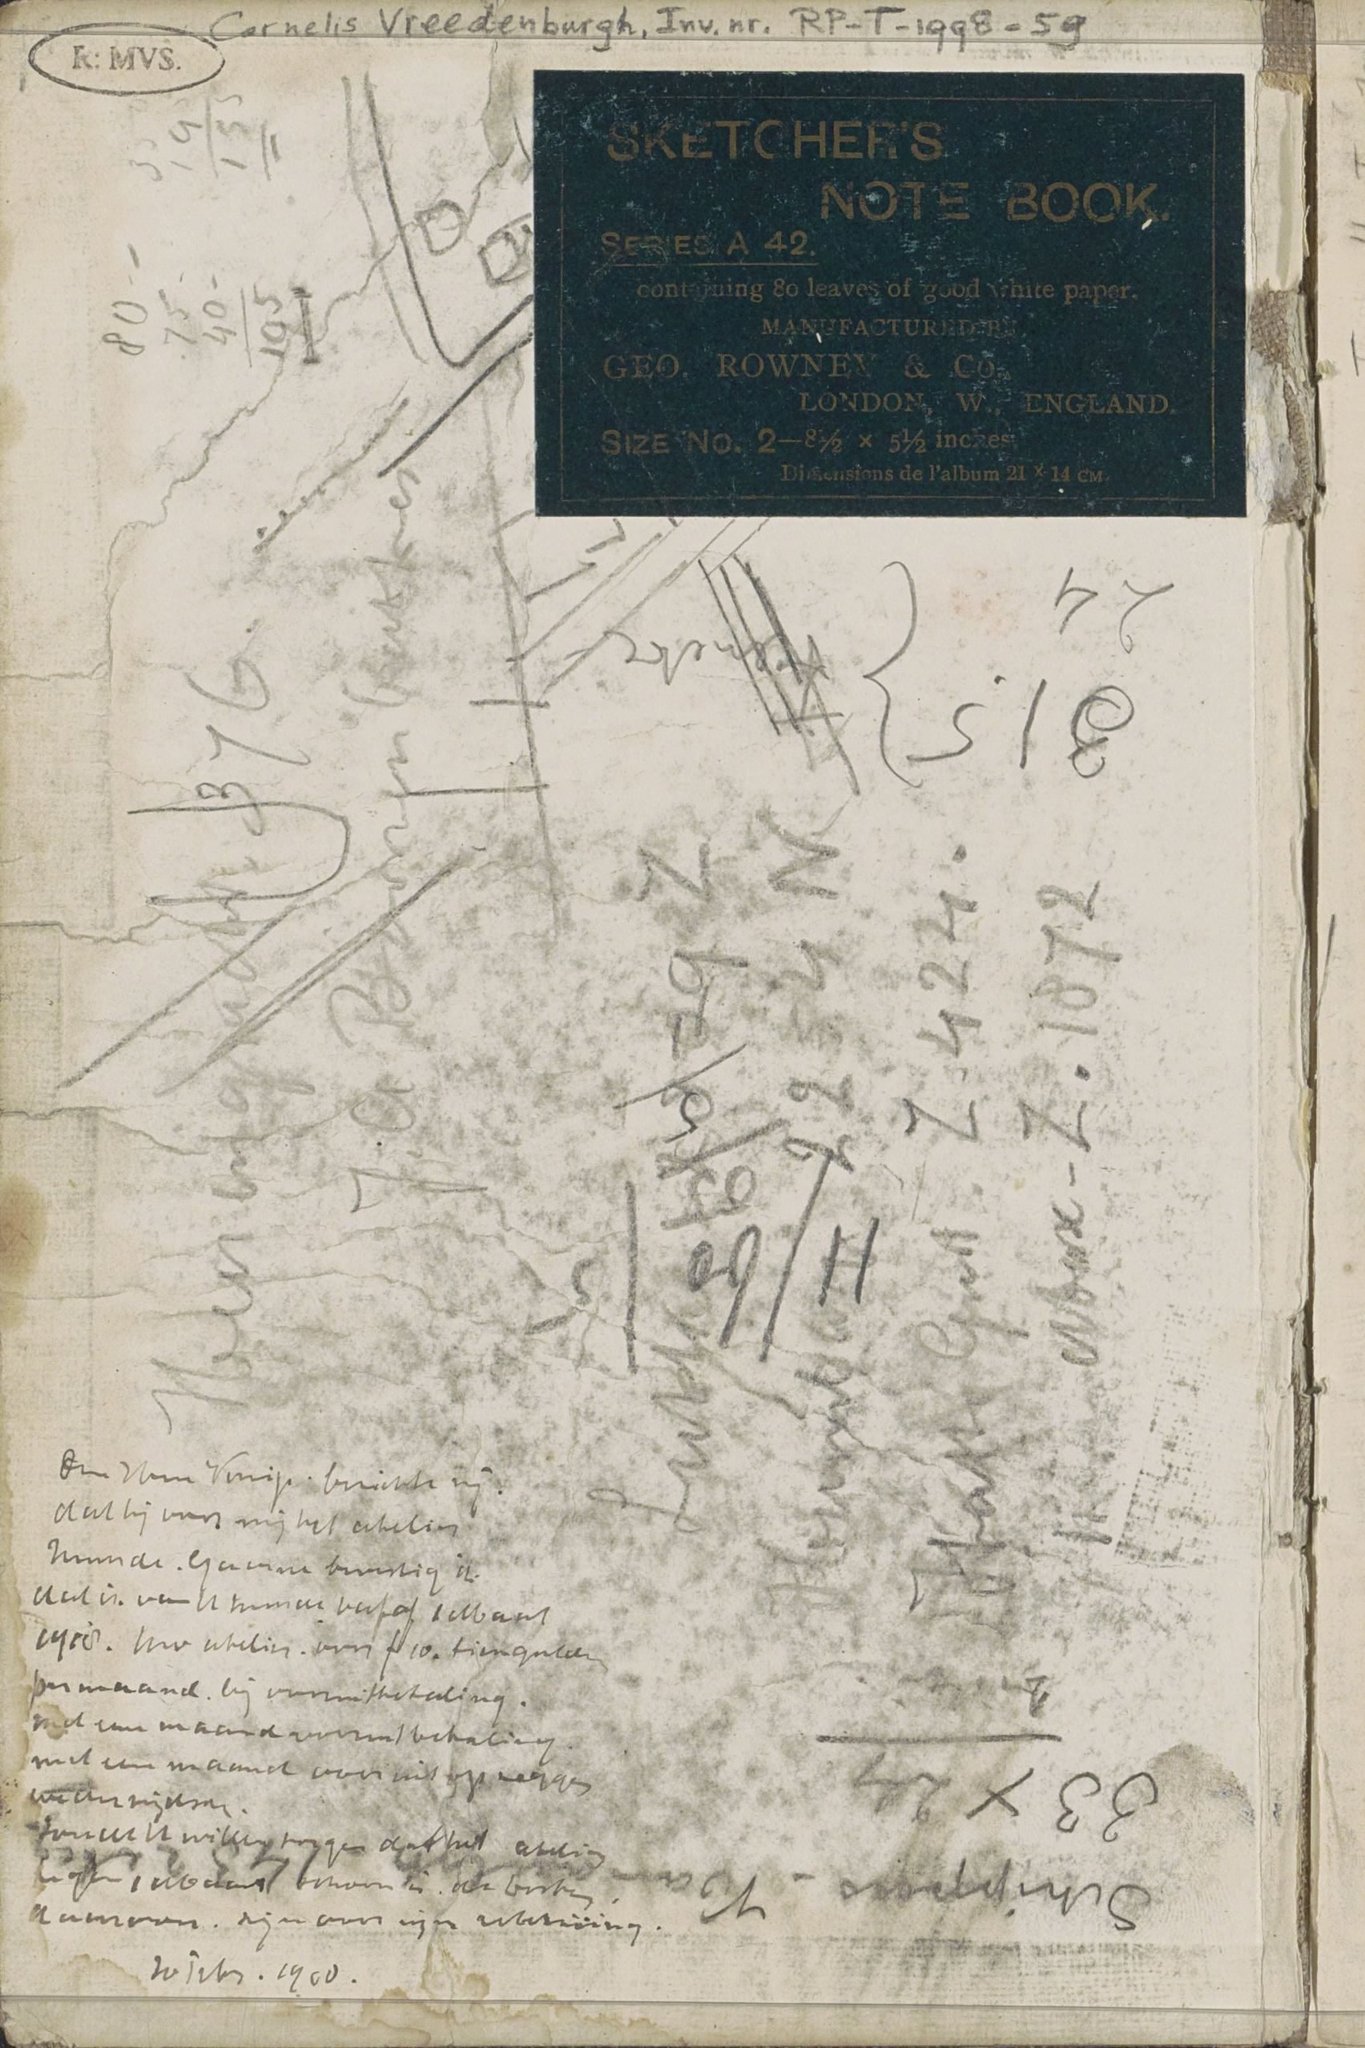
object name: sketchbook leaf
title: Studie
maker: cornelis vreedenburgh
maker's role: draughtsman, print maker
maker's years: 1880-1946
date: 1890-1946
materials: paper, pencil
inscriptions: date and inscription: ‘[....] zij/ dat hij van mij het atelier/ m[...]. Gaarne bevestig ik/ dat ik van U hoorde [...]/ 1918. Uw atelier door f 10 tien gulden/ per maand bij vooruitbetaling./ met een maand vooruitbetaling/ met een maand vooruit opzegging/ wederzijds[...]/ Zoude U wille [...]gen dat het atelier/ [...] in de [...]/ daarvoor zijn van zijn [...]ing/ 20 Febr 1908.’, collector's mark: Lugt 2228a, factory mark: ‘SKETCHER'S/ NOTE BOOK/ SERIES A 42/ containing 80 leaves of good white paper./ MANUFACTURED BY/ GEO. ROWNEY & CO., LONDON, W., ENGLAND/ SIZE No. 2- 8 1/2 x 5 1/2 inches./ Dimensions de l'album 21 x 14 cm.’, annotation: ‘Herengracht 376/ J.A. Bomen Lutkes/ Lubk[...]/ Schippers -K[...]’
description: Voorste schutblad uit een schetsboek met 47 bladen.